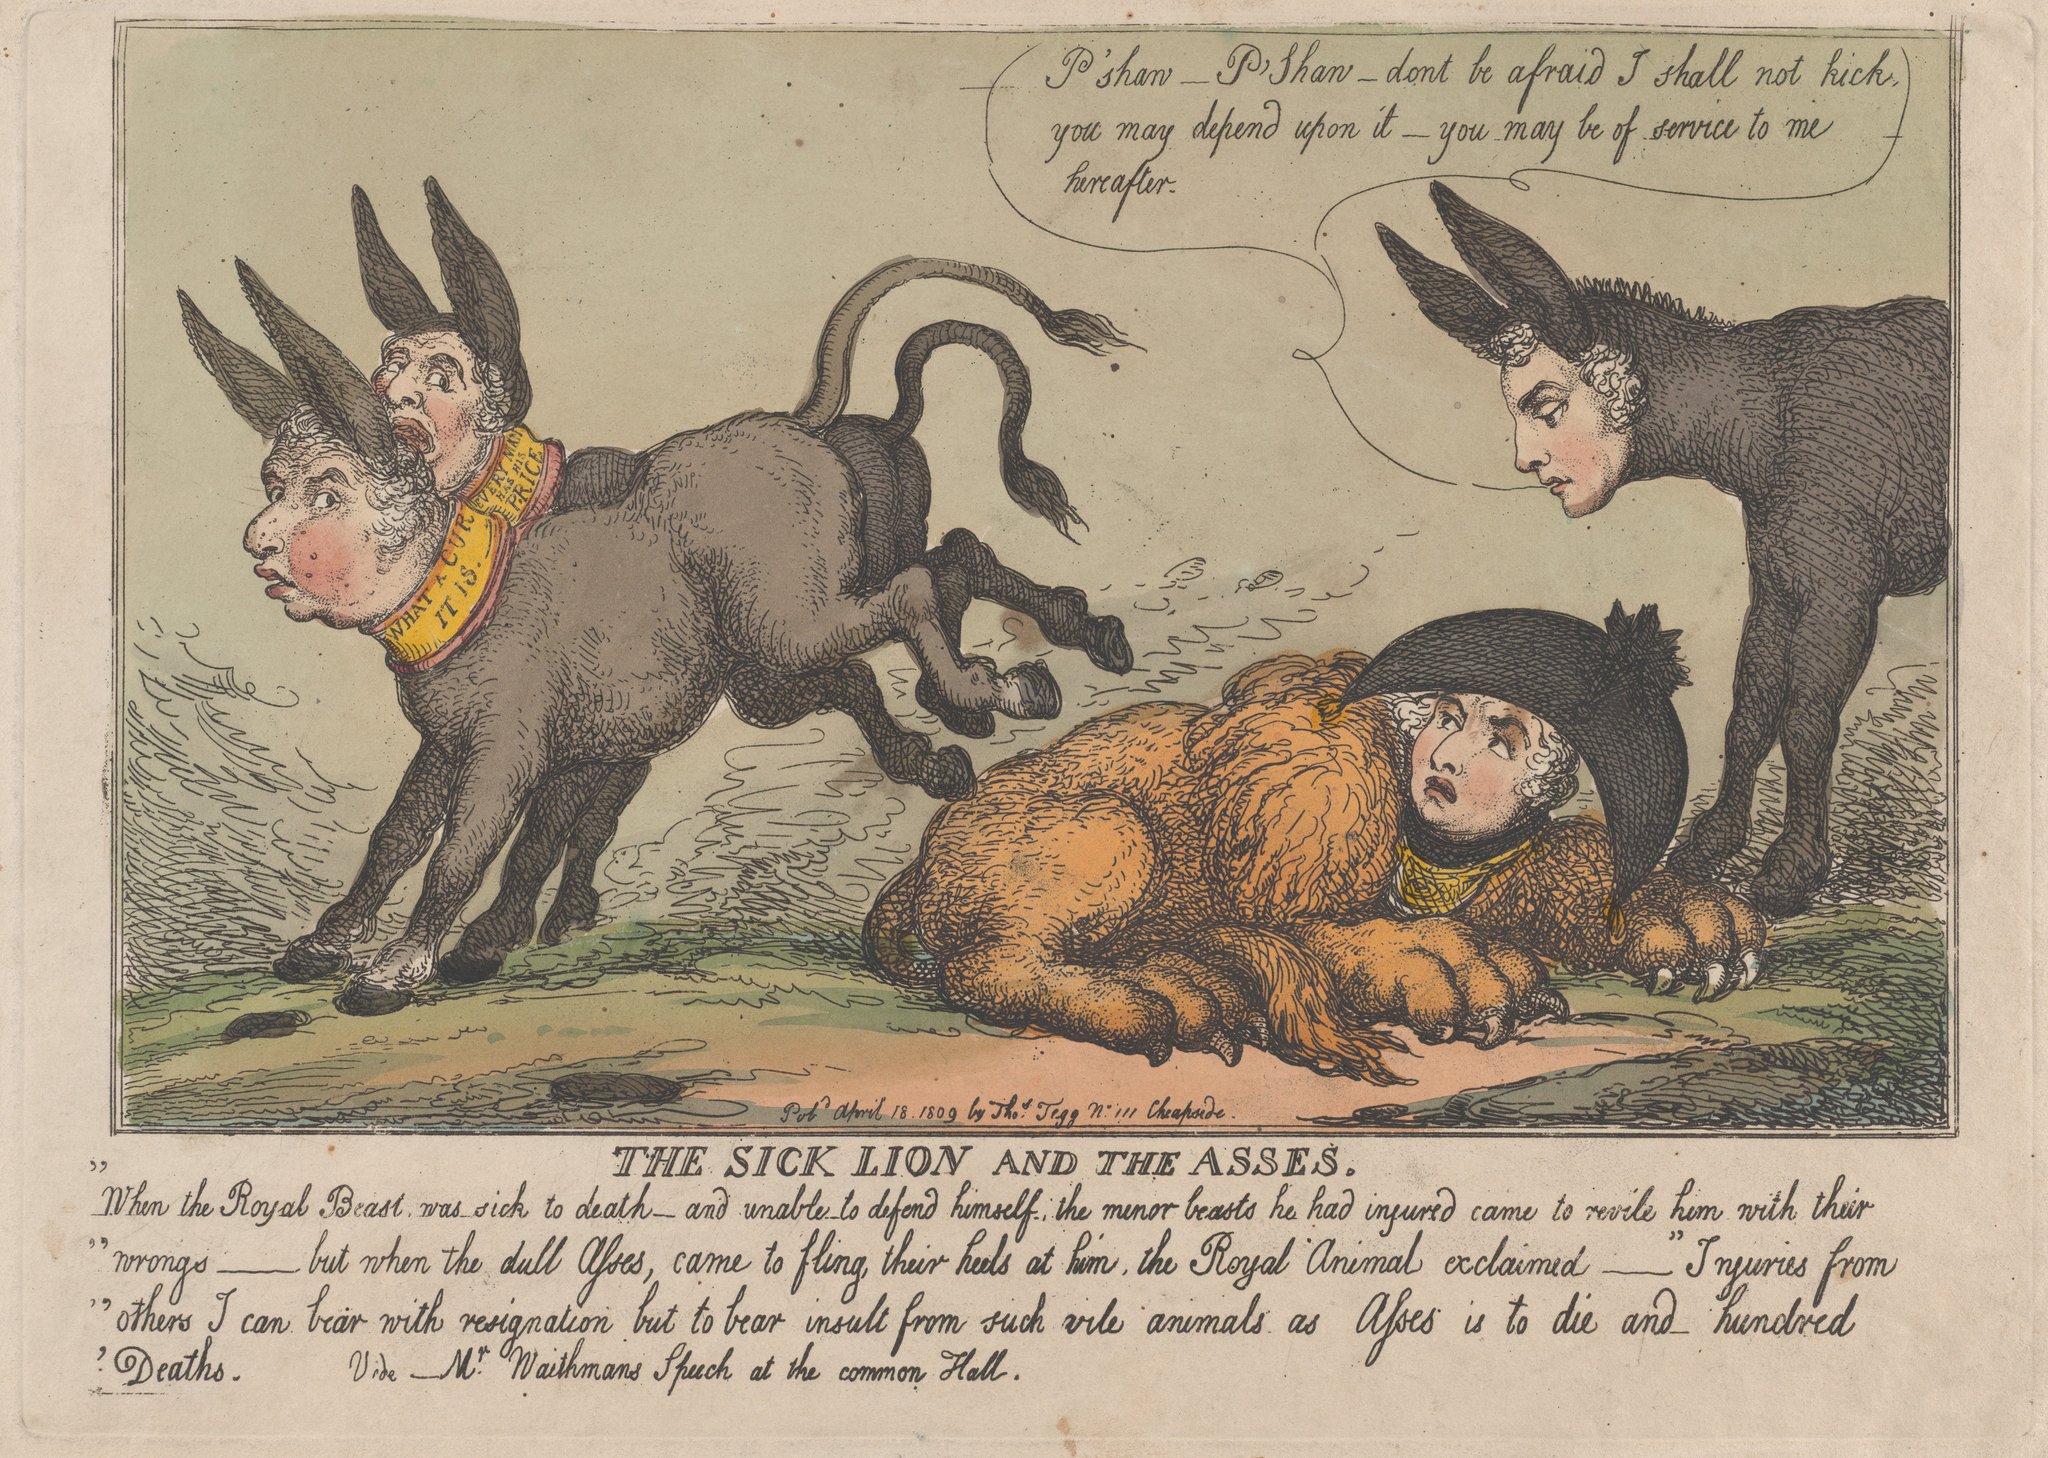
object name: print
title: The Sick Lion and The Asses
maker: thomas rowlandson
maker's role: artist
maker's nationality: british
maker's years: 1757-1827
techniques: etching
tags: satire,donkeys,lions,politics